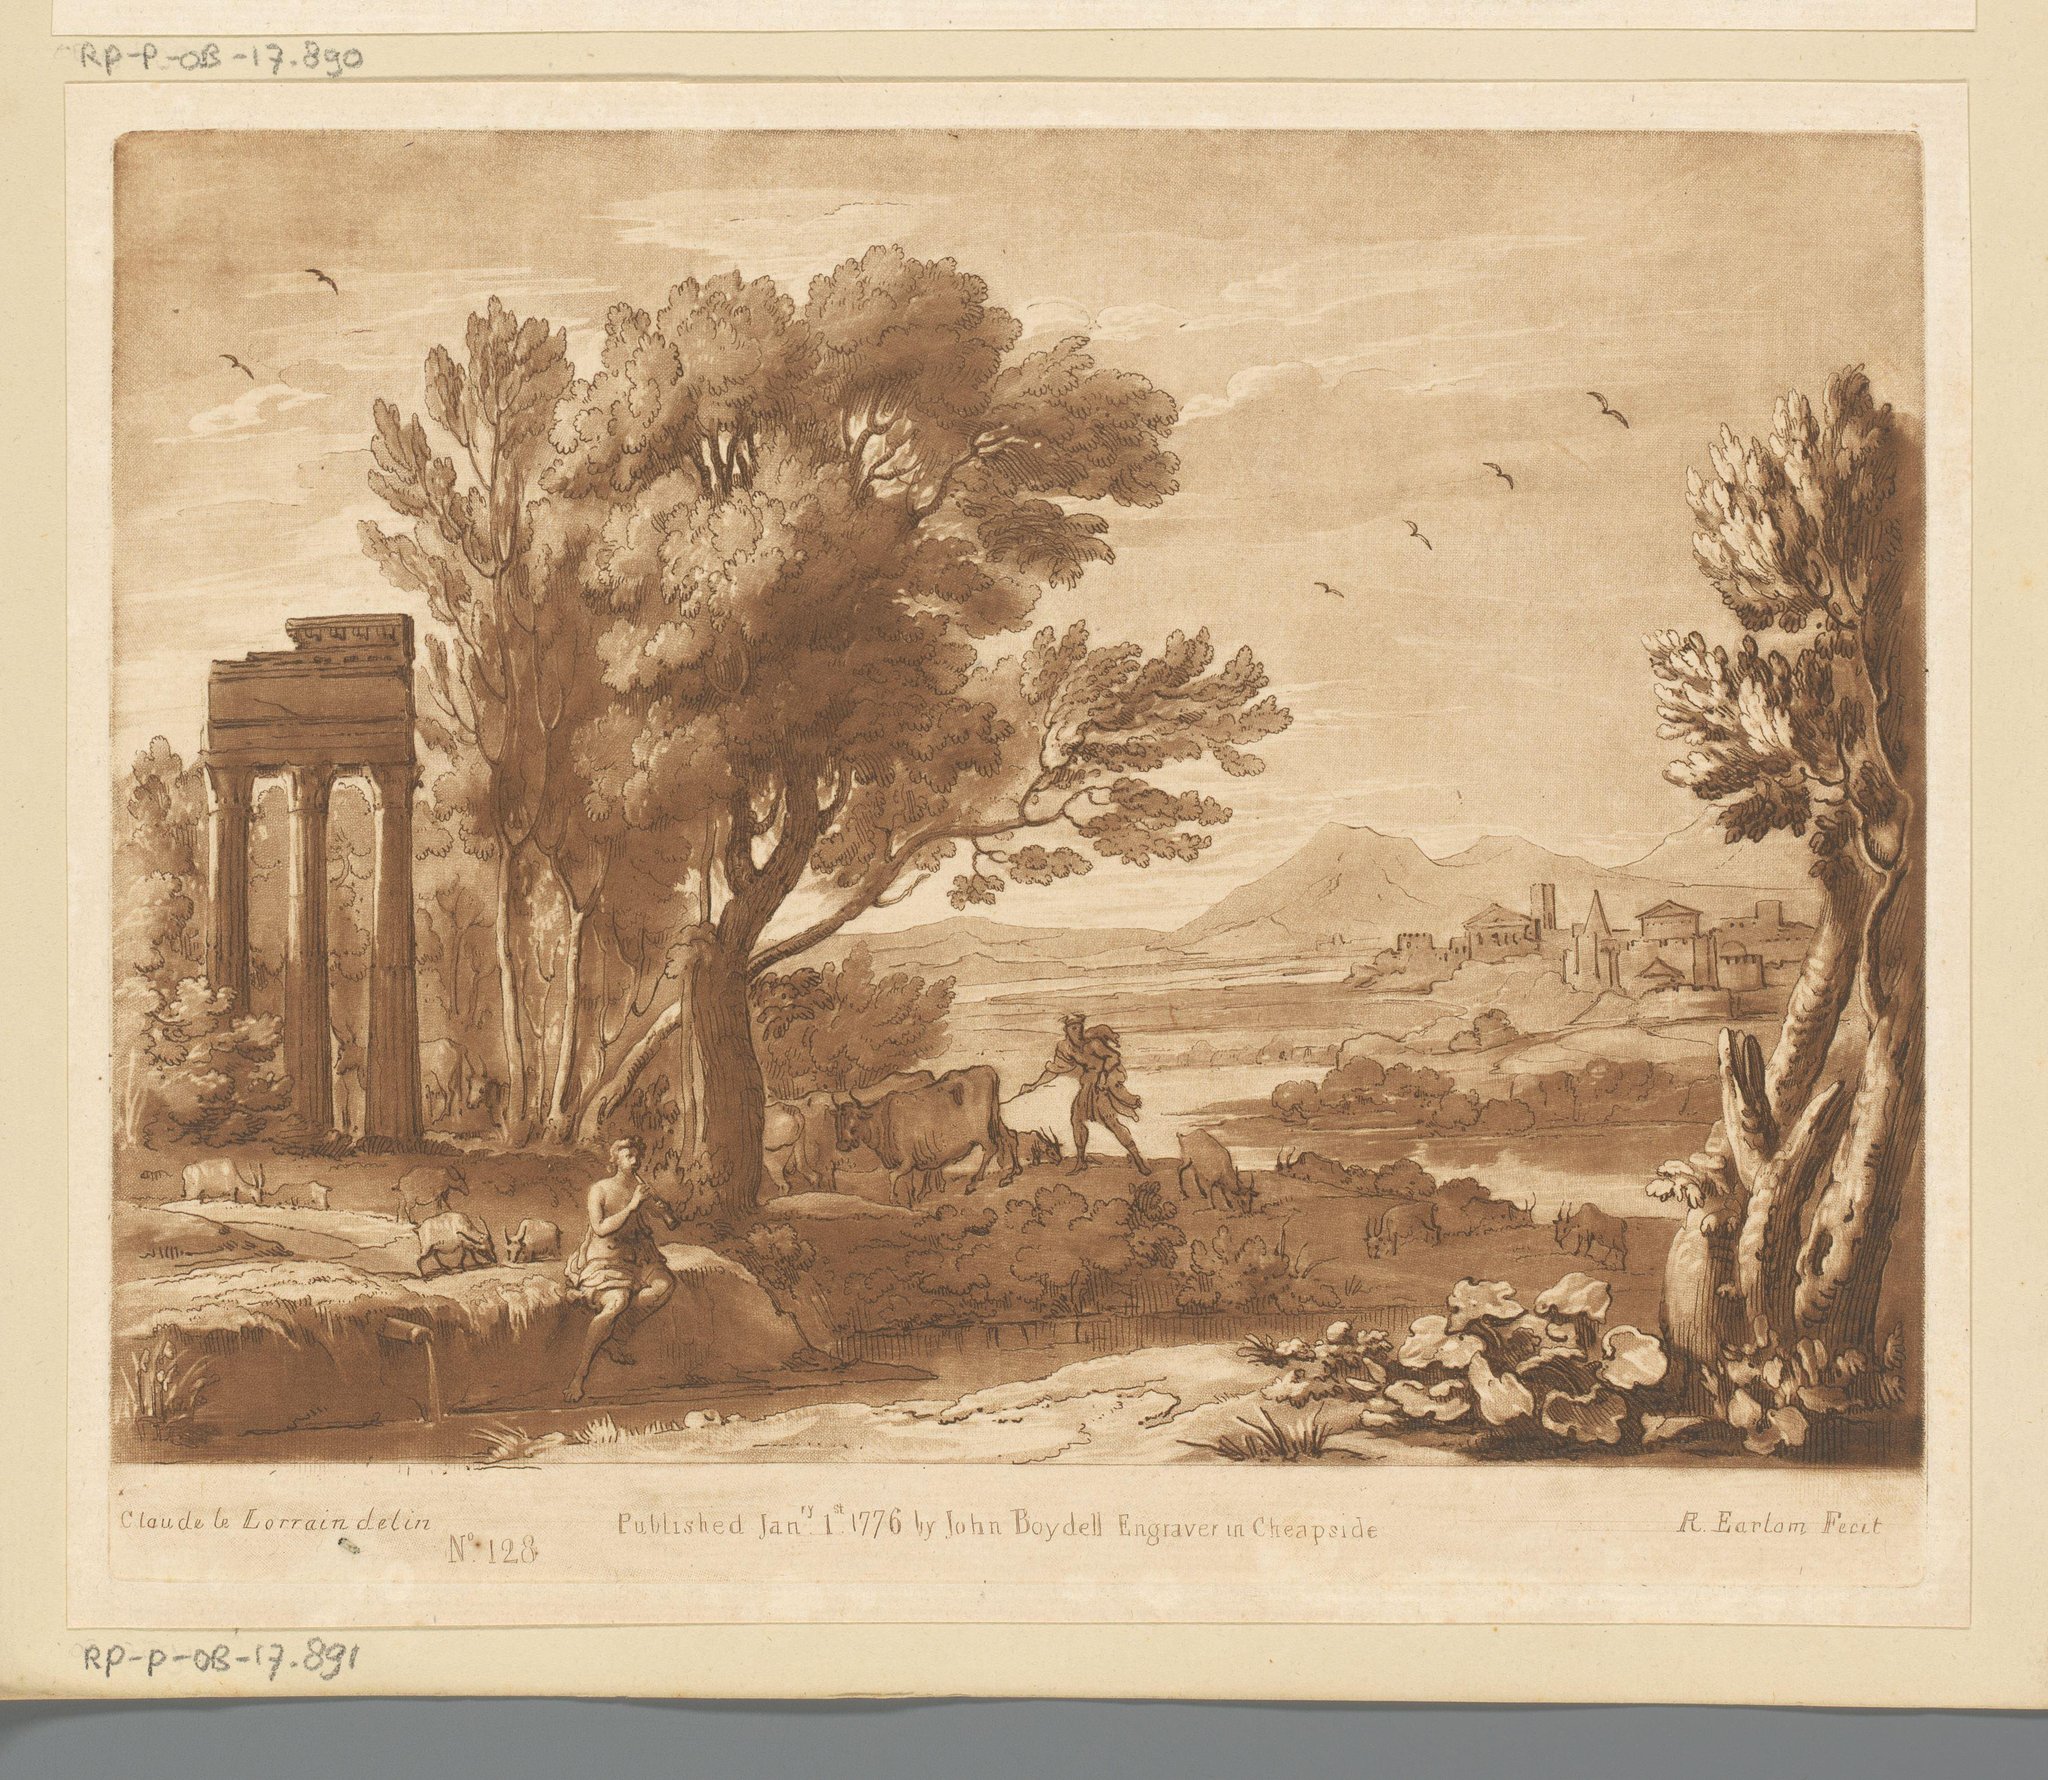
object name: print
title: Liber Veritatis. Or a Collection of Two Hundred Prints, after the original designs of Claude le Lorrain (...)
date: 1776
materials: paper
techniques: etching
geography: london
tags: city-view, and landscape with man-made constructions - ii - ideal landscapes, mercury and battus; battus is bribed with a heifer as hush-money, landscape with bridge, viaduct or aqueduct - ii - ideal landscapes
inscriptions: date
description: Vanaf 1774 publiceerde John Boydell tweehonderd prenten naar het tekeningenboek Liber Veritatis van Claude Lorrain, in het bezit van de hertogen van Cavendish. Deze prenten werden vanaf 1777 in twee volumes gebundeld uitgegeven.